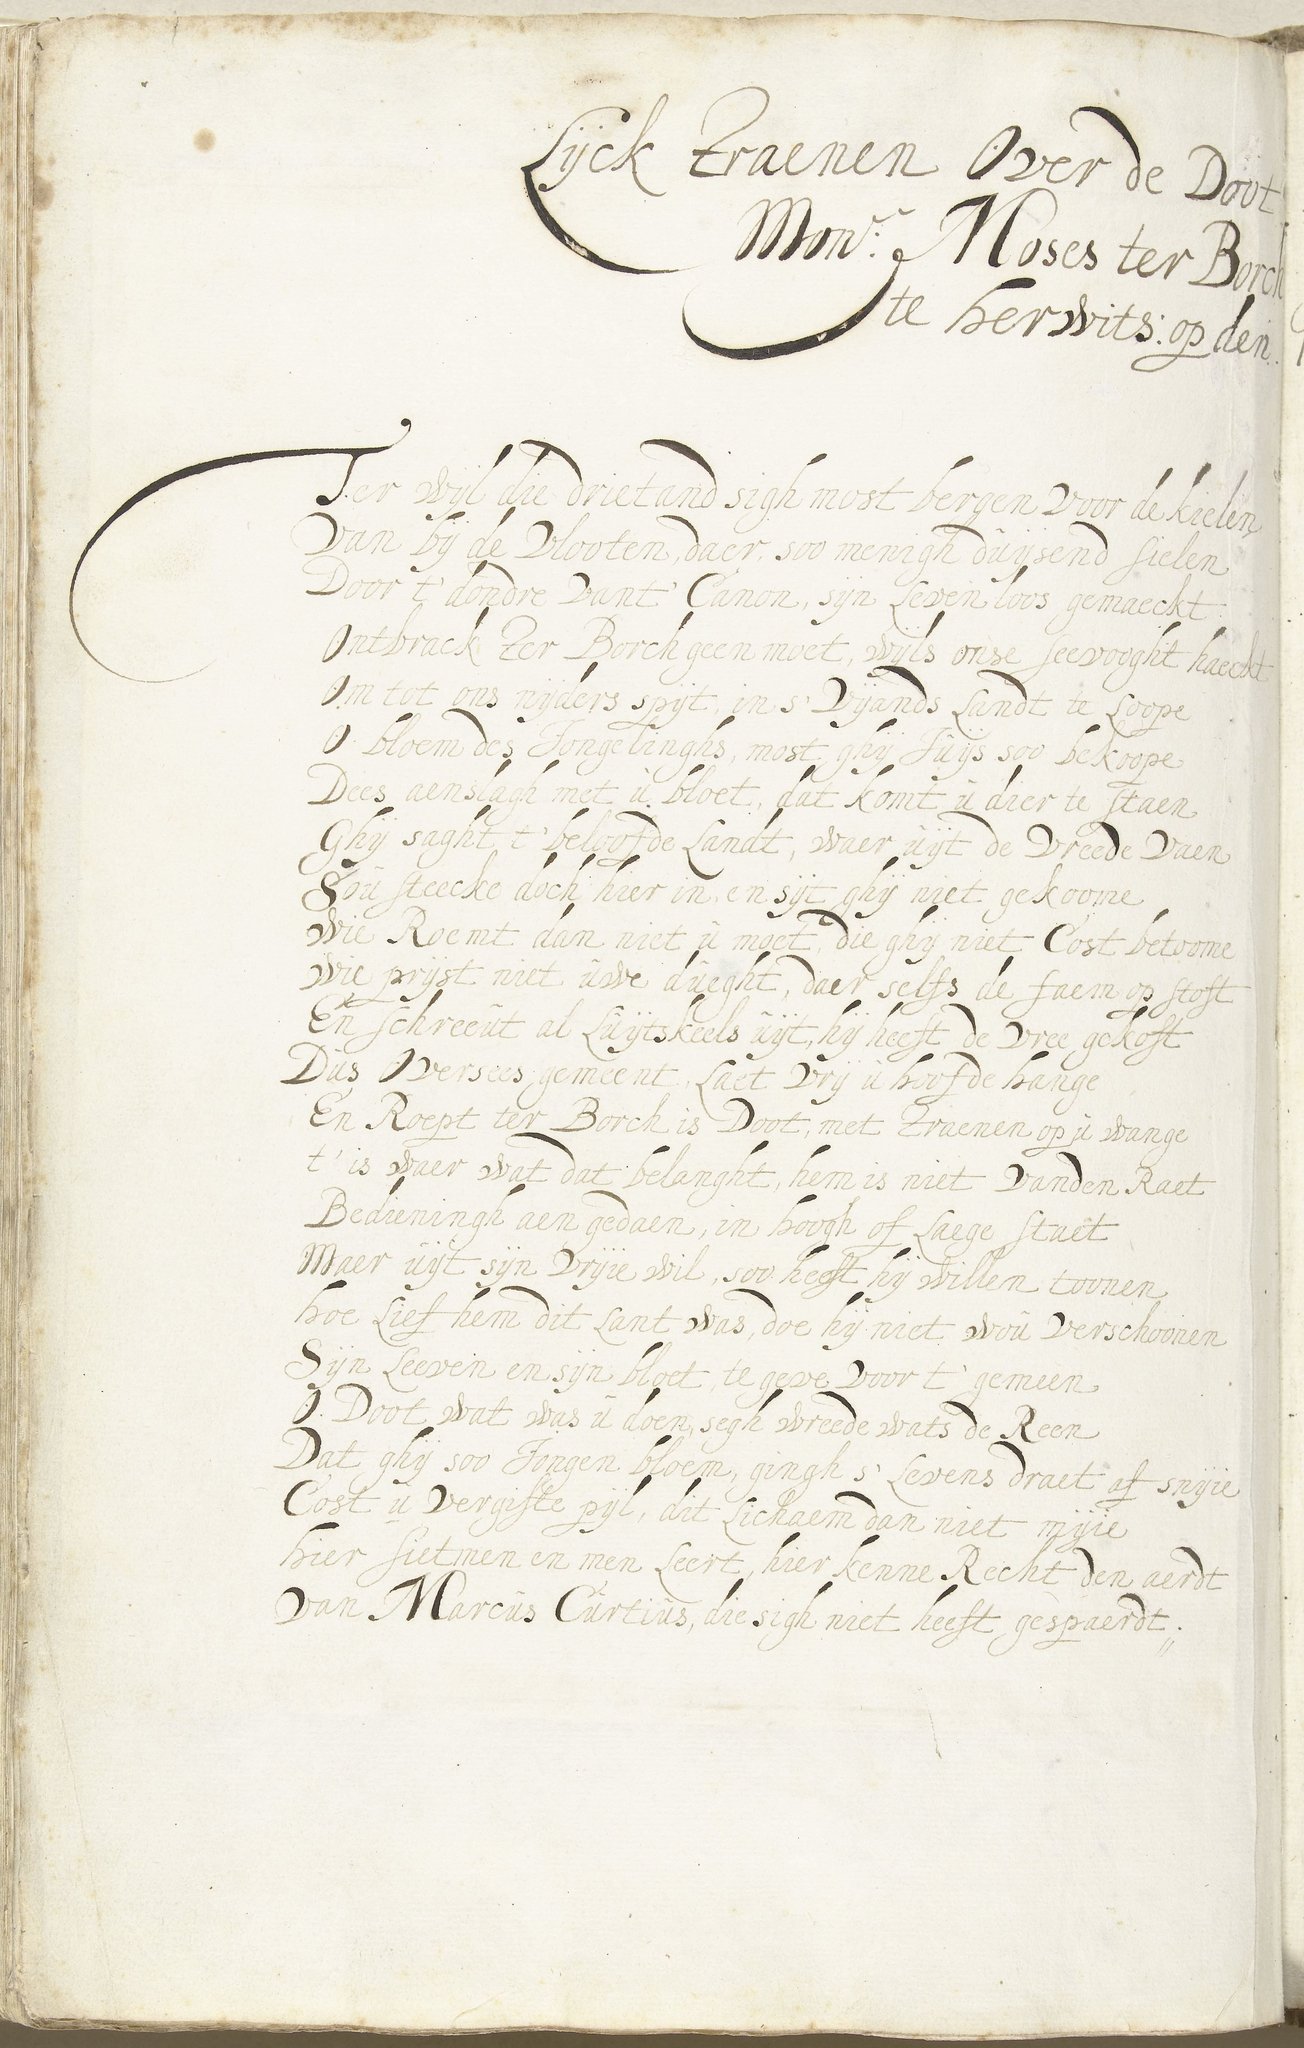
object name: poem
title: Rouwgedicht voor Moses ter Borch (deel 1)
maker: gesina ter borch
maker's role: draughtsman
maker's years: 1633-1690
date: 1667-1670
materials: ink, paper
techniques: calligraphy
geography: zwolle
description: Rouwgedicht voor Moses ter Borch, gevallen voor het Kasteel te Harwich op 12 juli 1667; zonder aangegeven melodie. Zie voor deel 2 van het gedicht BI-1890-1952-110.